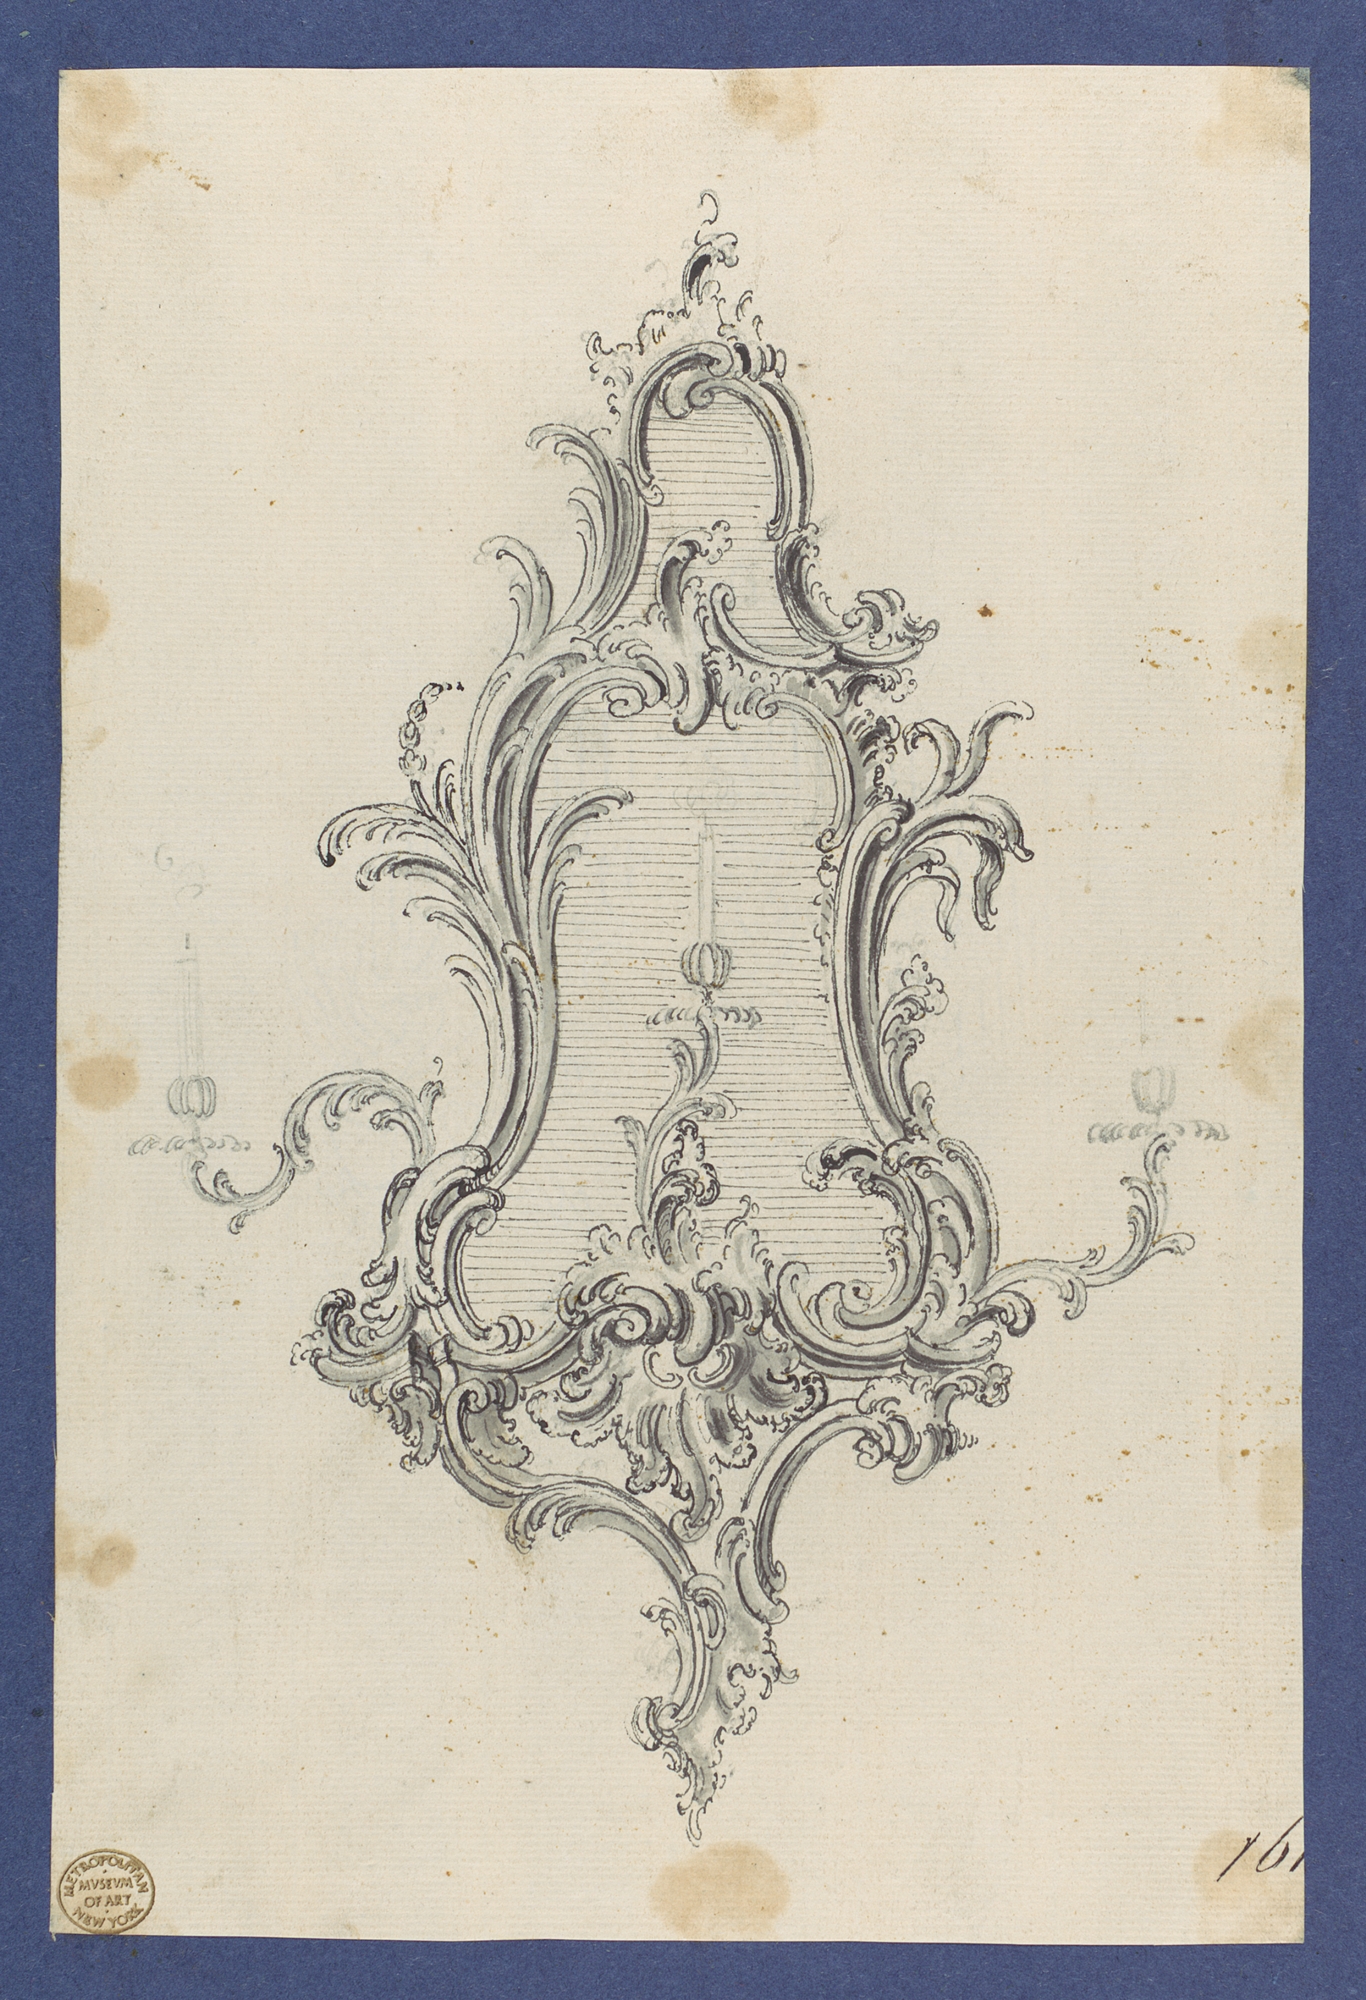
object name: drawing ornament architecture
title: Mirror with Sconces, in Chippendale Drawings, Vol. I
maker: thomas chippendale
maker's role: artist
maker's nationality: british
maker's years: 1718-1779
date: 1753-1762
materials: graphite, ink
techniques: wash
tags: ornament,mirrors